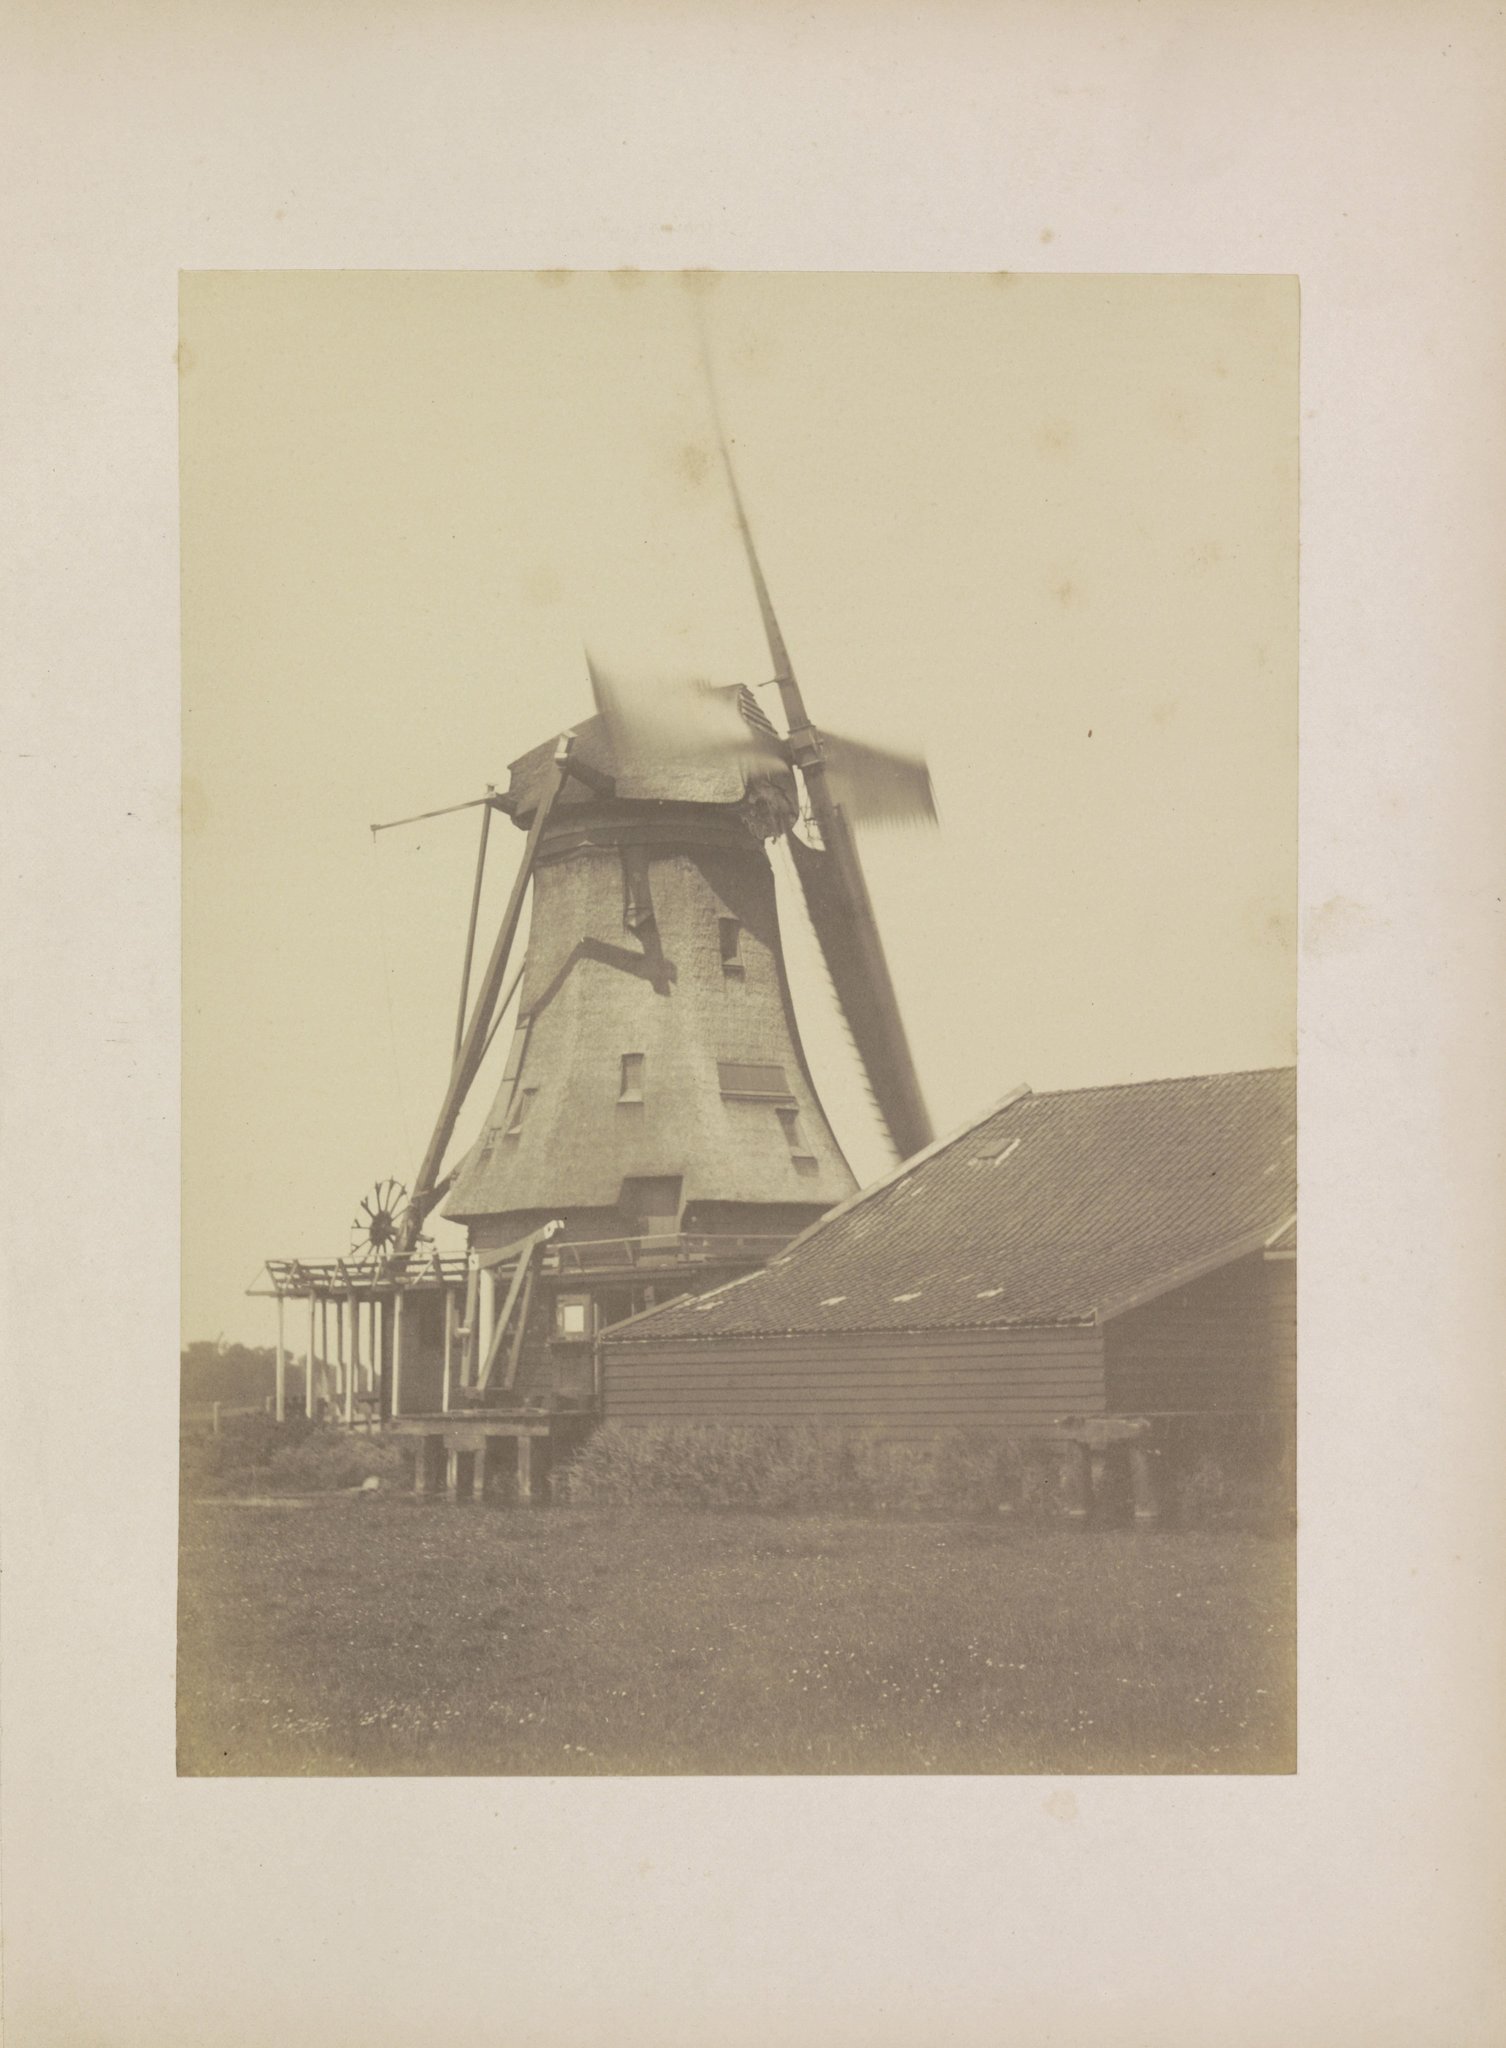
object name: photograph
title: Zaandam (gedeeltelijk afgesneden)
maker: Anonymous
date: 1885-1900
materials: paper, photographic support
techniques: albumen print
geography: france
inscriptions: annotation: ‘Zaandam (gedeeltelijk afgesneden)’